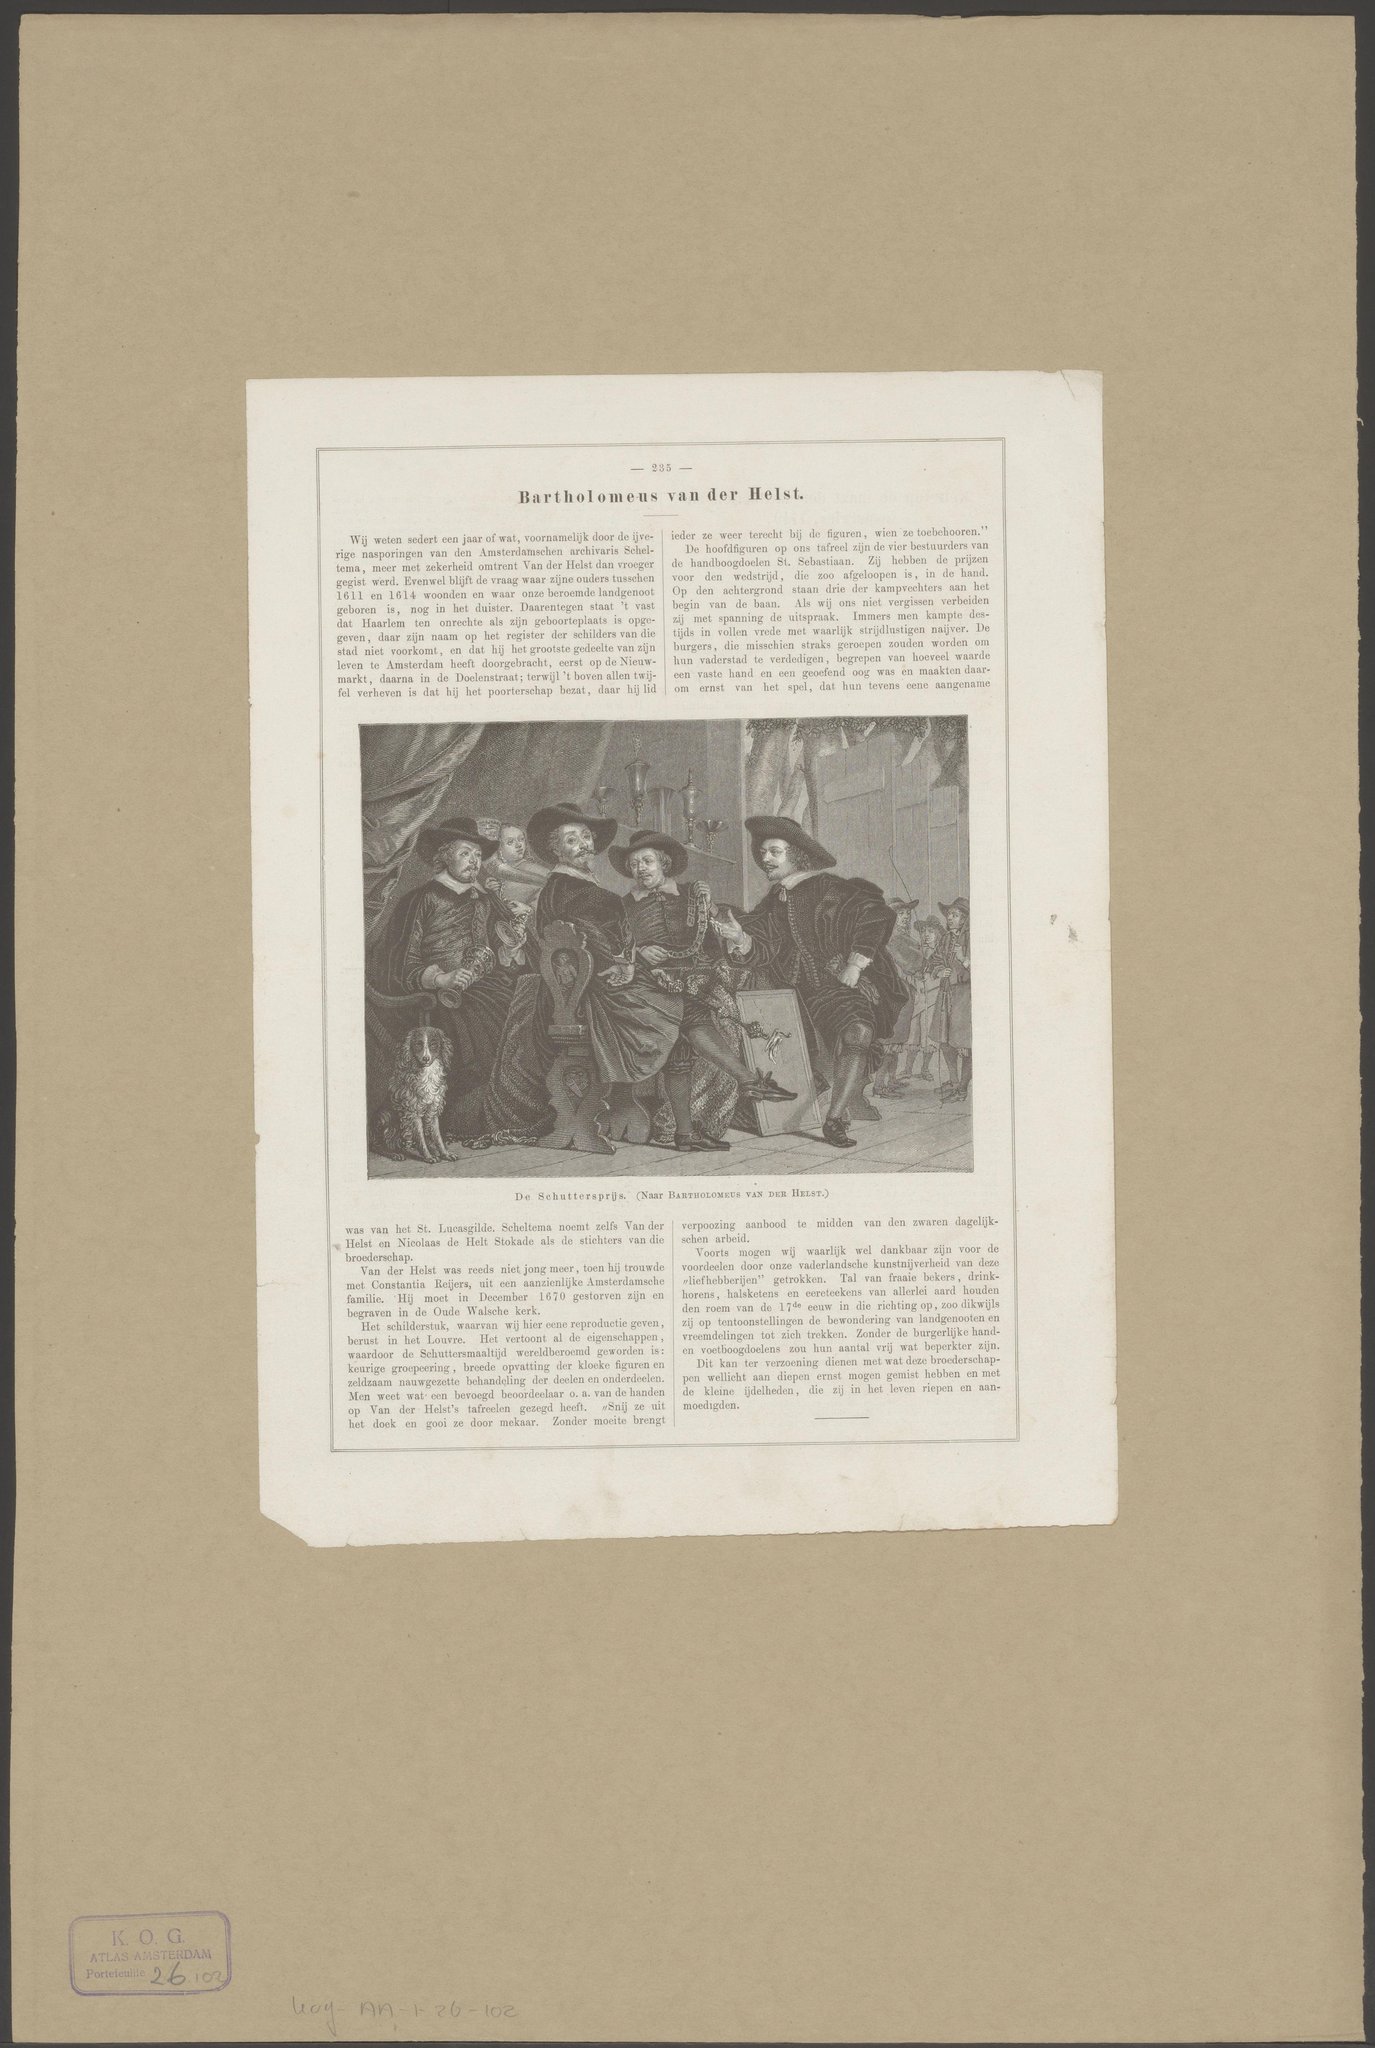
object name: print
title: Bartholomeus van der Helst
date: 1806-1880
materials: paper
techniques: letterpress printing, engraving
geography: amsterdam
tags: publisher, johannes willemszoon blaeu, mayor, frans banninck cocq, insignia of a guild, historical persons, dog, amsterdam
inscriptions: collector's mark: Lugt 1641b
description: Onderwerpsrubriek binnen de Atlas Amsterdam: Herinneringen aan de Schutterij.